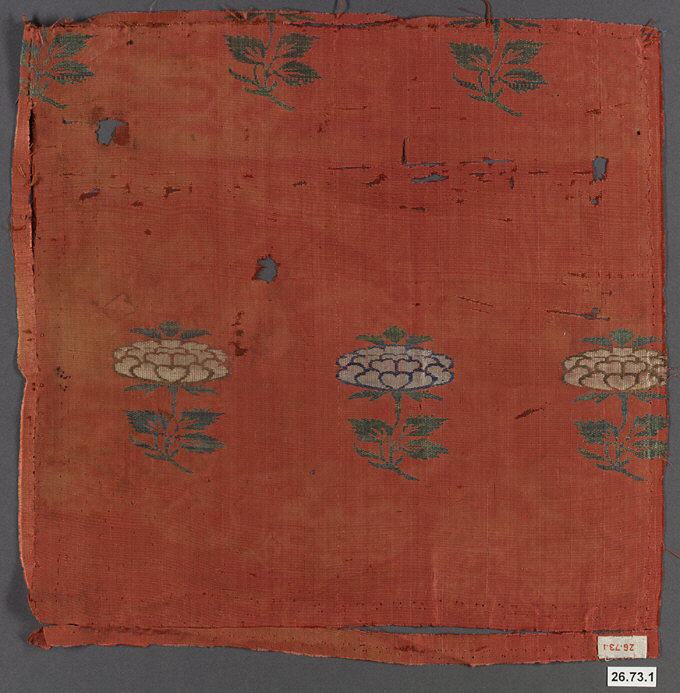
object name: textile fragment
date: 1601-1700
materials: silk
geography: iran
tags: flowers